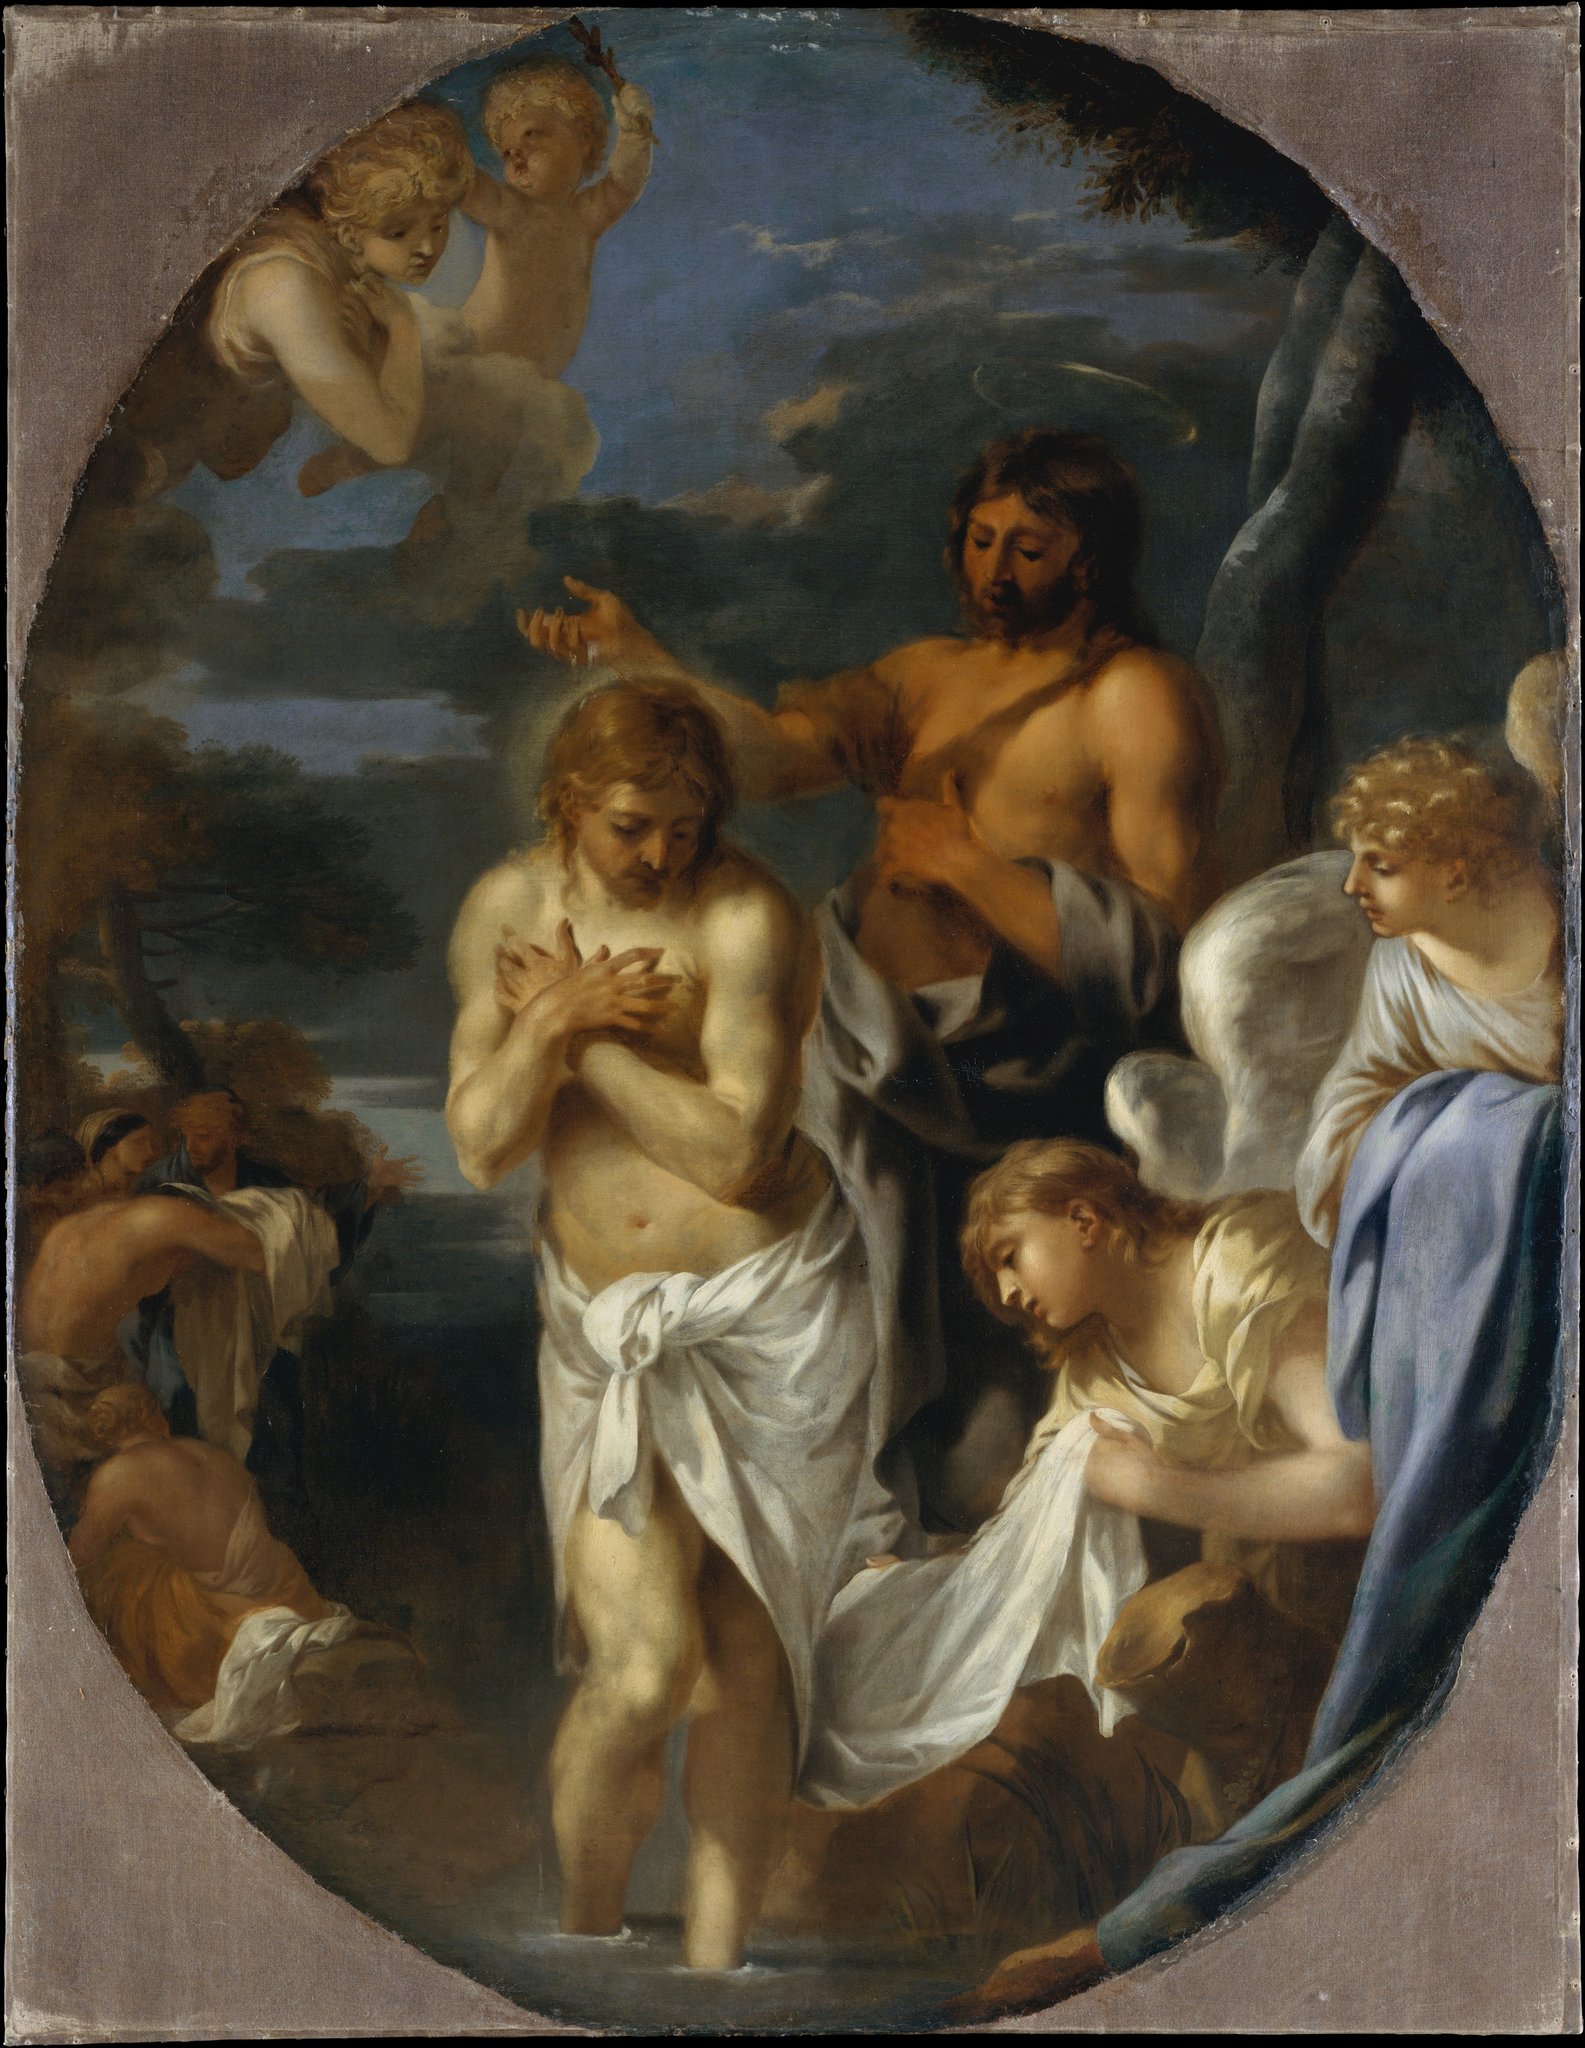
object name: painting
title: The Baptism of Christ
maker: sébastien bourdon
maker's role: artist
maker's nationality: french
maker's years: 1616-1671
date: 1650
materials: canvas, oil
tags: angels,saint john the baptist,baptism of christ